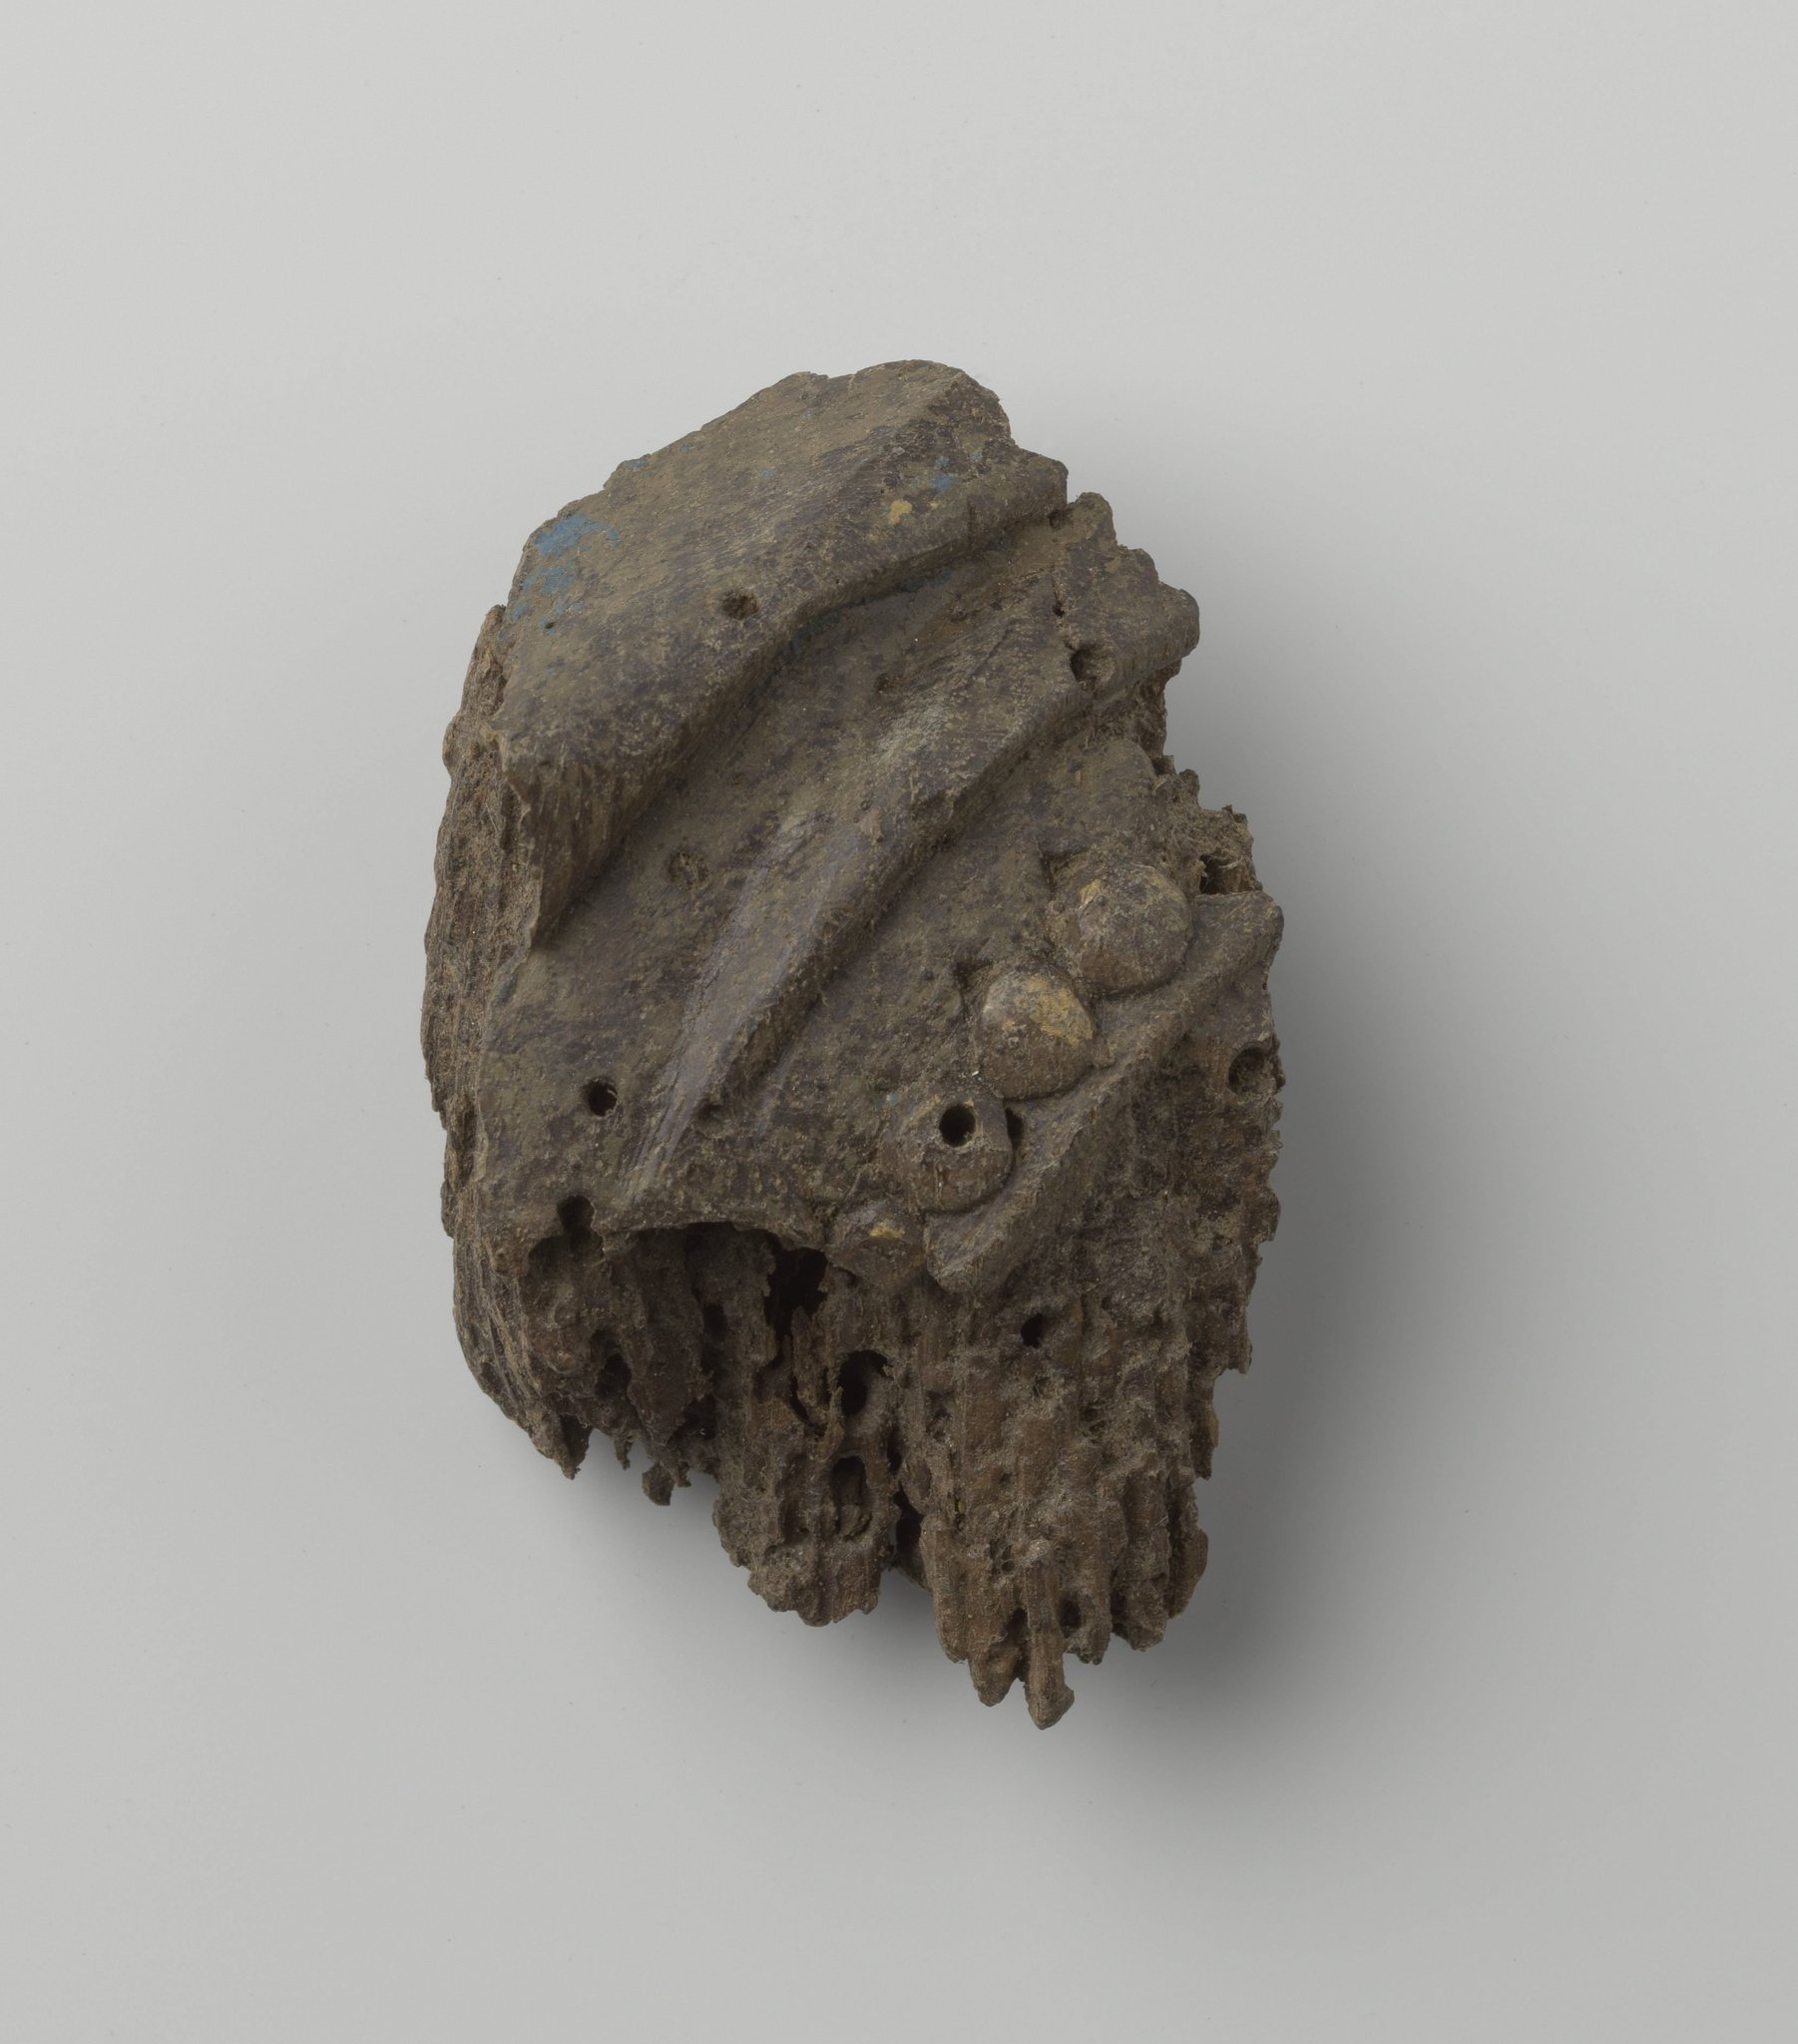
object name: sculpture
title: Fragment; (mogelijk) behorend tot het retabel van Soest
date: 1475-1499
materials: wood